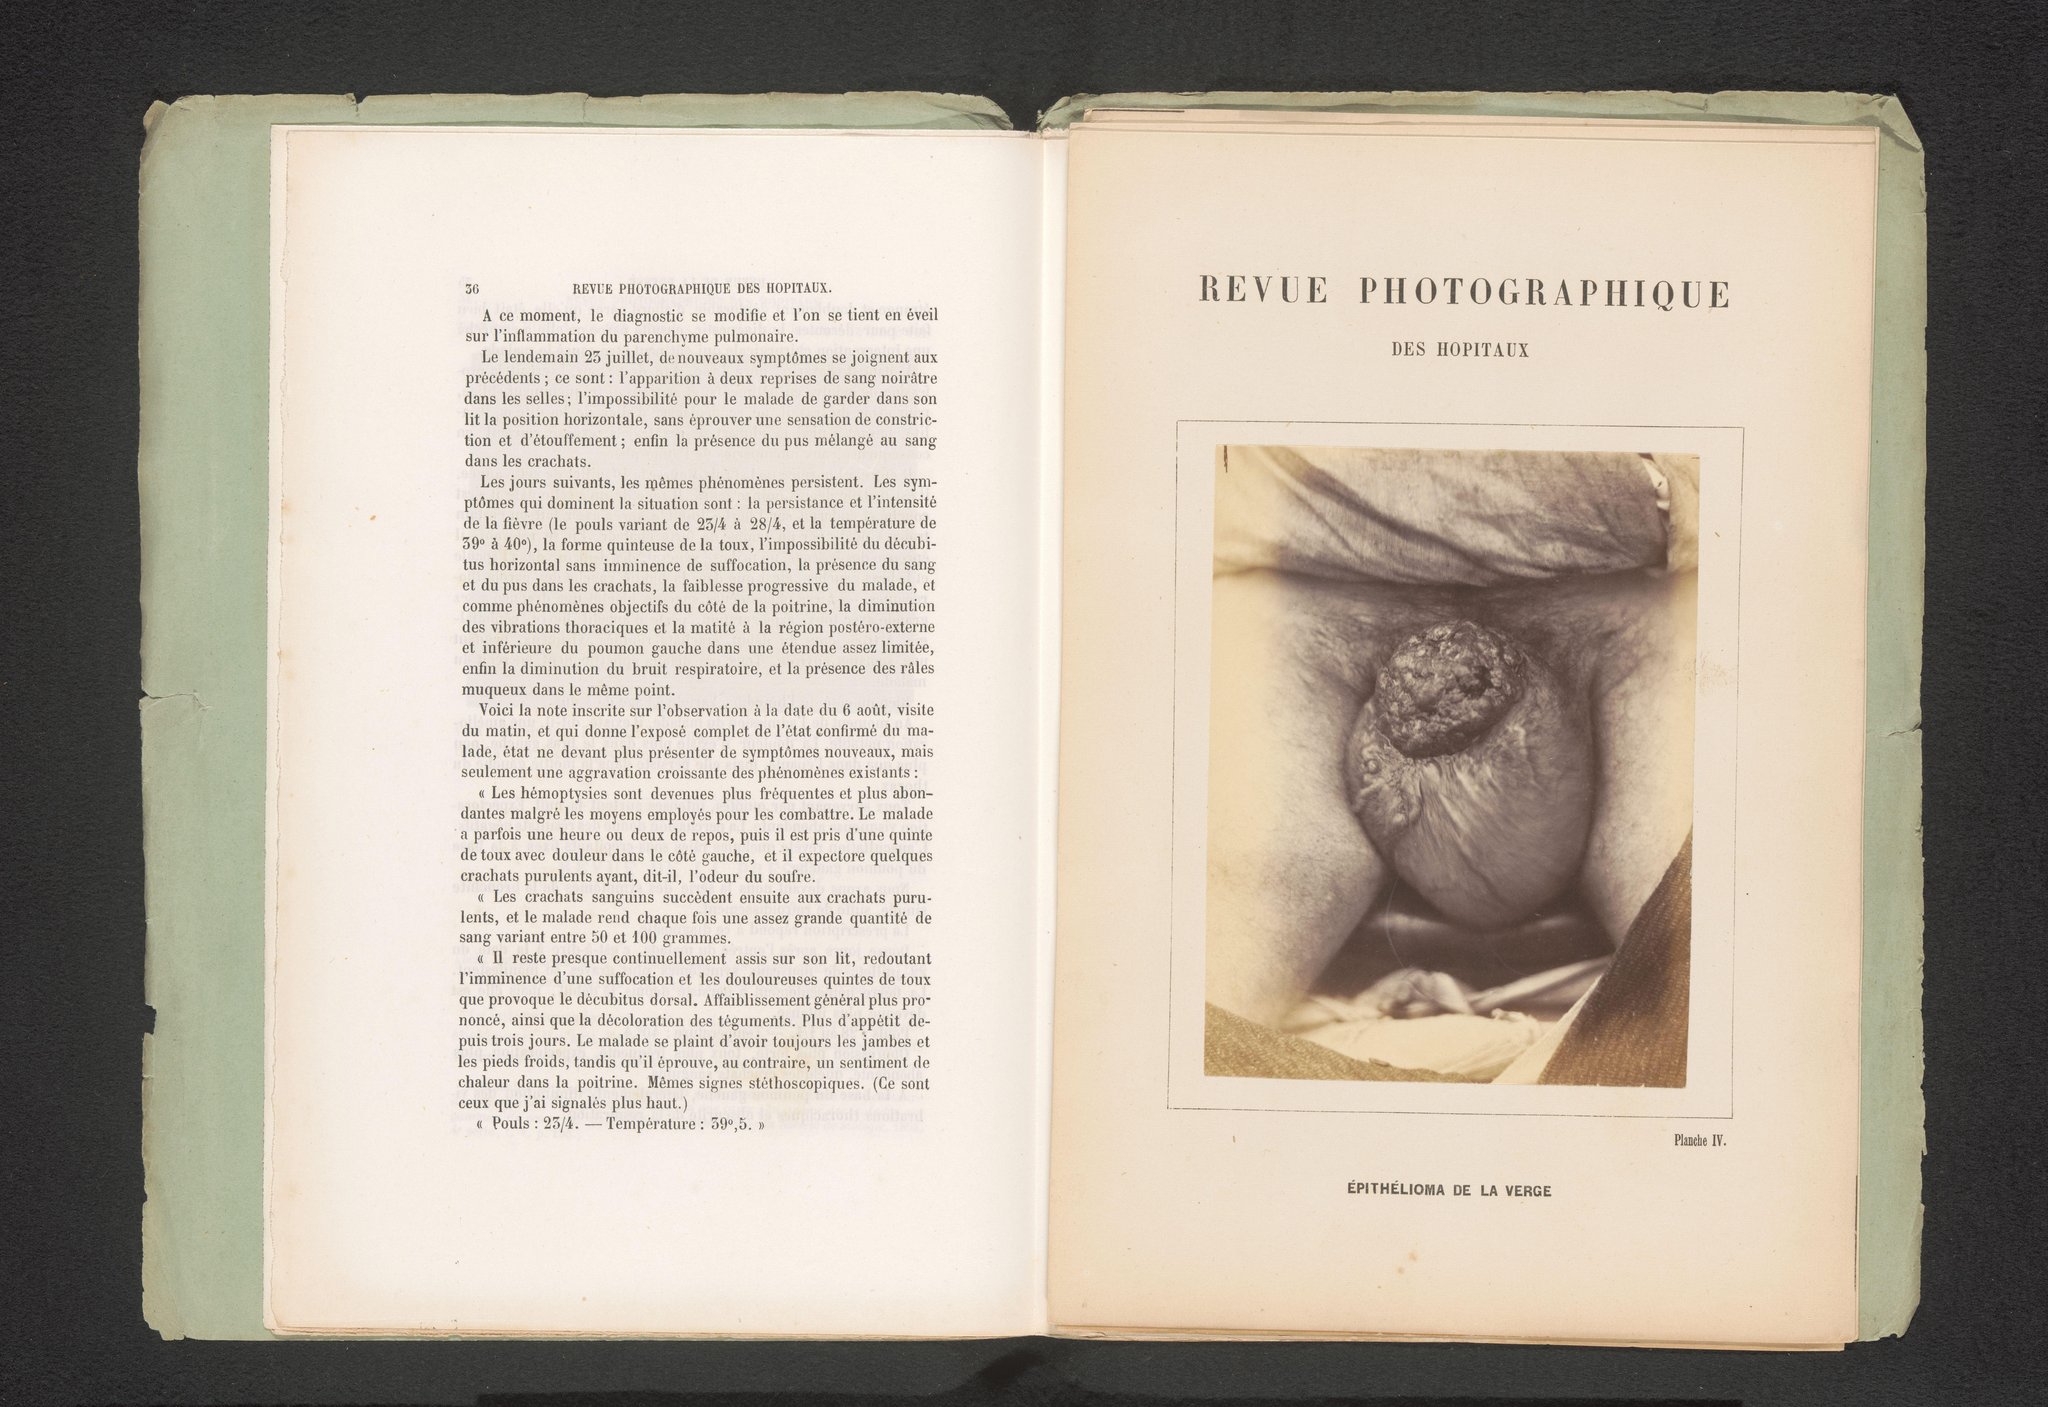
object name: photograph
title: Épithélioma de la verge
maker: Anonymous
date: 1865-1870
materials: paper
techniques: albumen print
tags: external tumours, penis, phallus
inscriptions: inscription: ‘Revue photographique/ des hopitaux/ Planche IV.’